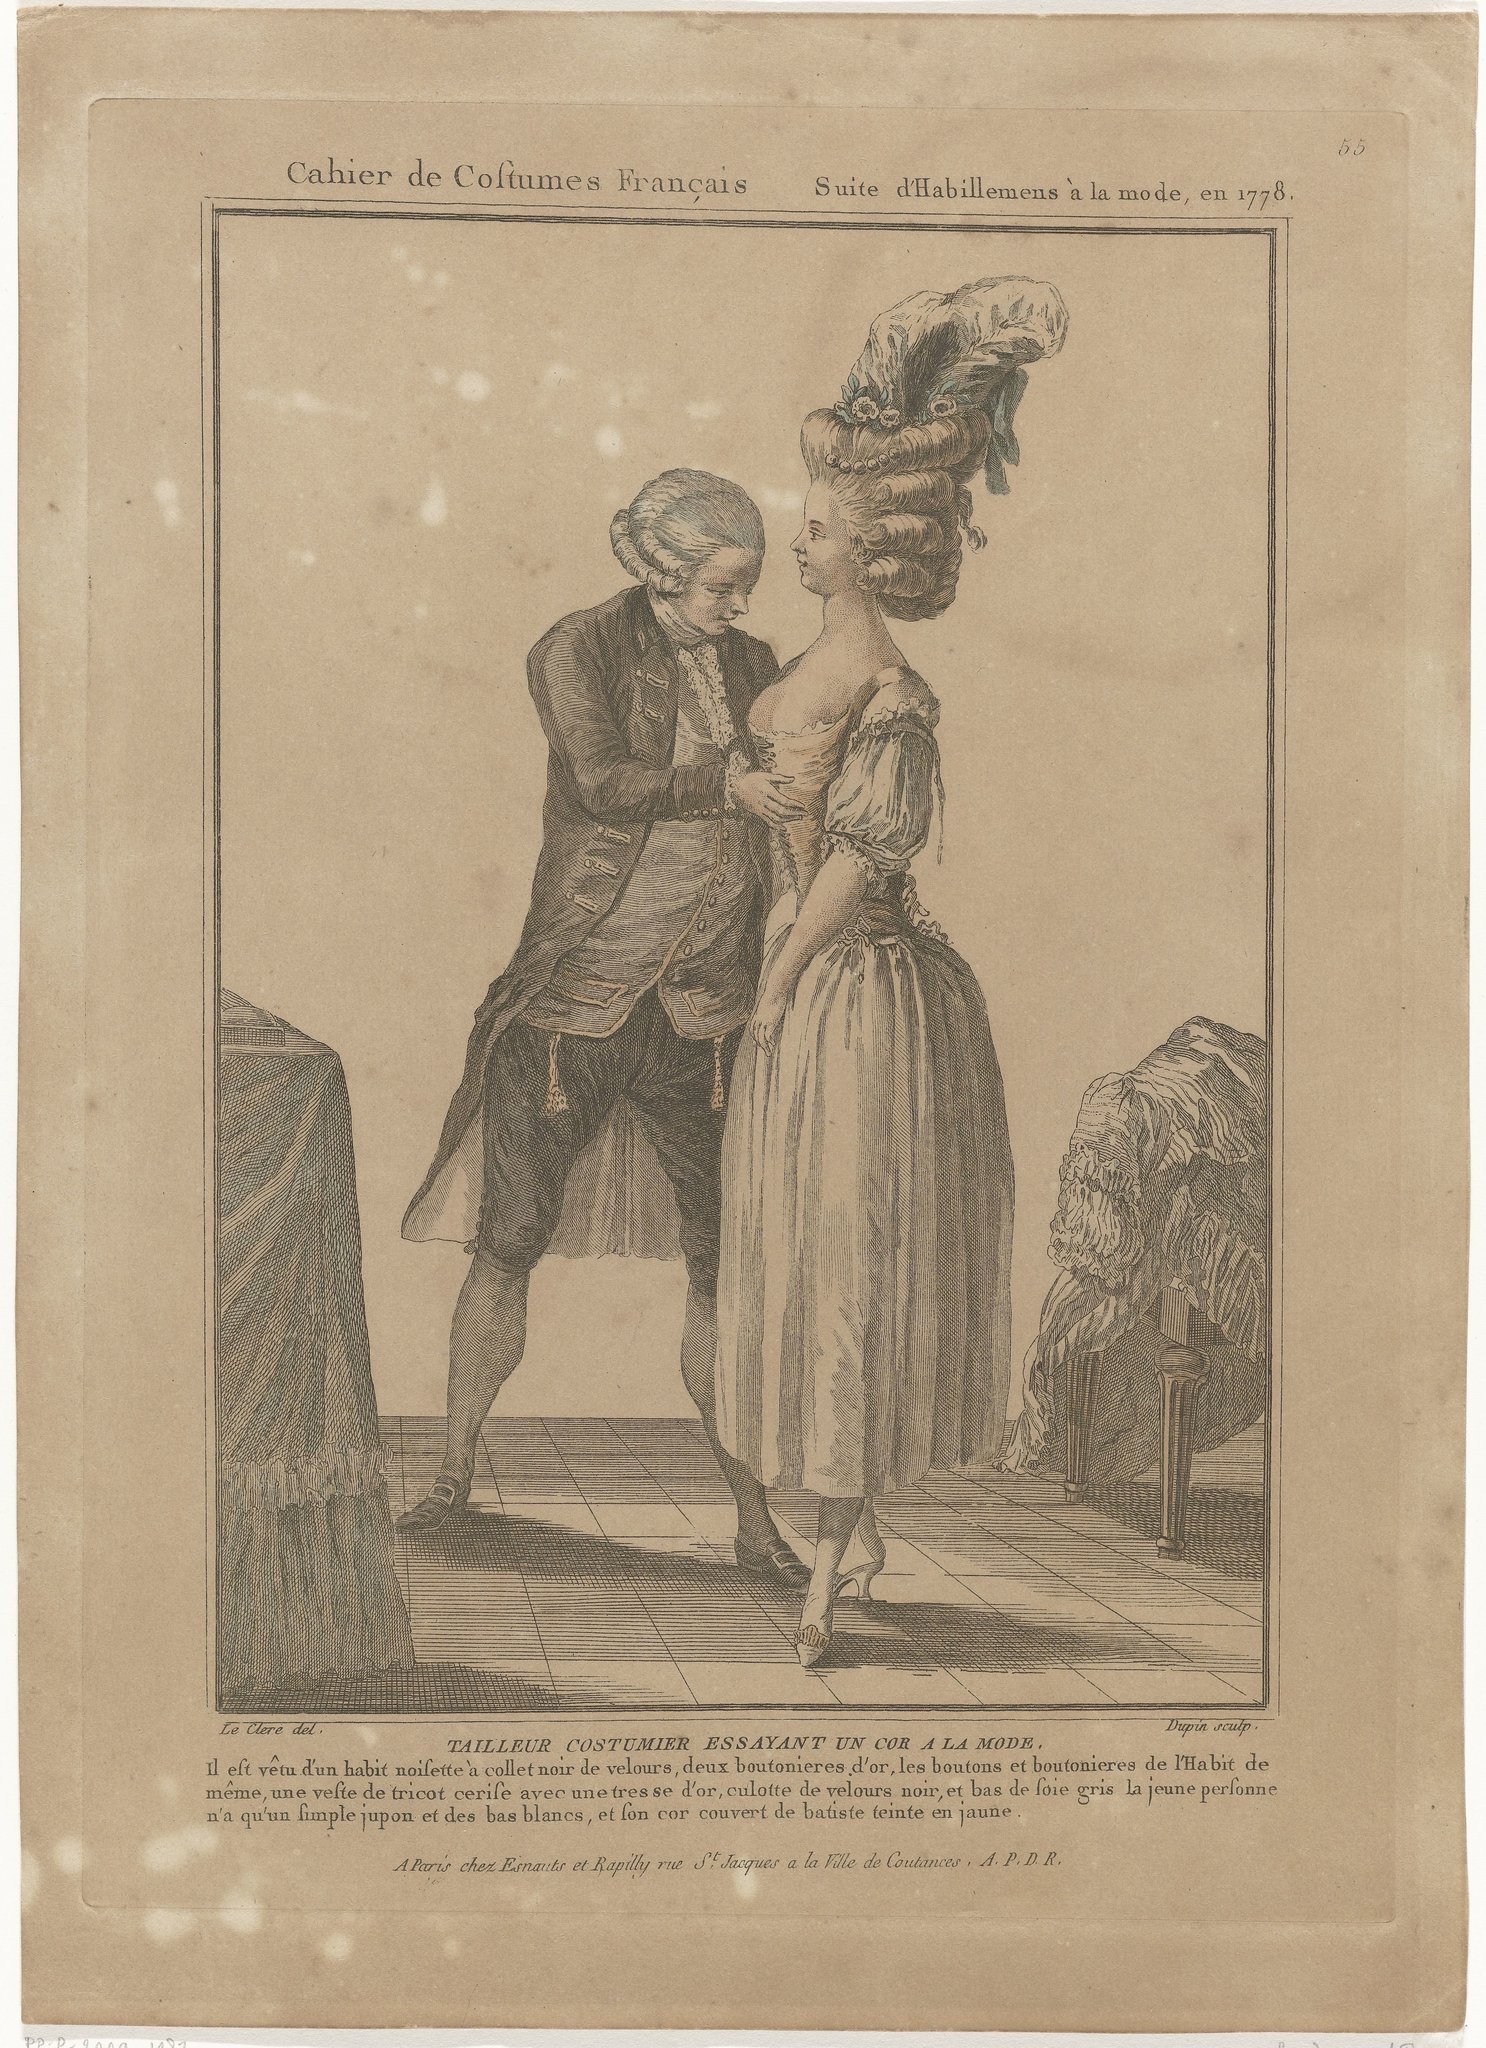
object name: fashion print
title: Gallerie des Modes et Costumes Français, 1778, P 85 : Tailleur costumier essayant un cor de la mode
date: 1778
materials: paper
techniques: engraving, hand coloring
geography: paris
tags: clothing for the upper part of the body (vest) (+ men's clothes), underclothes for the whole body (+ women's clothes), underclothes for the upper part of the body: corset (+ women's clothes), neck-gear ~ clothing (+ men's clothes), coat (+ men's clothes), styles of hairdress - aa - ~ women, head-gear: cap (+ women's clothes), fashion plates, shoes, sandals (+ women's clothes), shoes, sandals (+ men's clothes), stockings, socks (+ women's clothes), trousers, breeches, etc. (breeches) (+ men's clothes), stockings, socks (+ men's clothes)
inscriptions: caption: ‘Il est vêtu d'un habit noisette à collet noir de velours, deux boutonieres d'or, les boutons et boutonieres de l'Habit de même, une veste de tricot cerise avec une tresse d'or, culotte de velours noir, et bas de soie gris: la jeune personne n'a qu'un simple jupon et des bas blancs, et son cor couvert de batiste teinte en jaune’, title: ‘Tailleur costumier essayant un cor de la mode.’, inscription: ‘Cahier de Costumes Français Suite d'Habillemens à la mode, en 1778.’, address: ‘A Paris chez Esnauts et Rapilly rue St. Jacques a la Ville de Coutances. A.P.D.R.’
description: De kleermaker past een jonge vrouw een korset aan. Hij draagt een 'habit' met fluwelen kraag op een vest van tricot en kniebroek van fluweel. Gerimpelde jabot en manchetten. In de taille twee breloques. Kousen van grijze zijde en schoenen met vierkante gespen. De jonge vrouw draagt een korset van gele batist. Onderrok en witte kousen. Muiltjes aan de voeten. Op het opgekapte haar een muts met lint, veer en bloemen. Rechts is een japon over een stoel gedrapeerd. Prent uit de serie P. 15e Cahier de Costumes Français, 9e Suite d'Habillemens à la mode en 1778, Gallerie des Modes et Costumes Français.